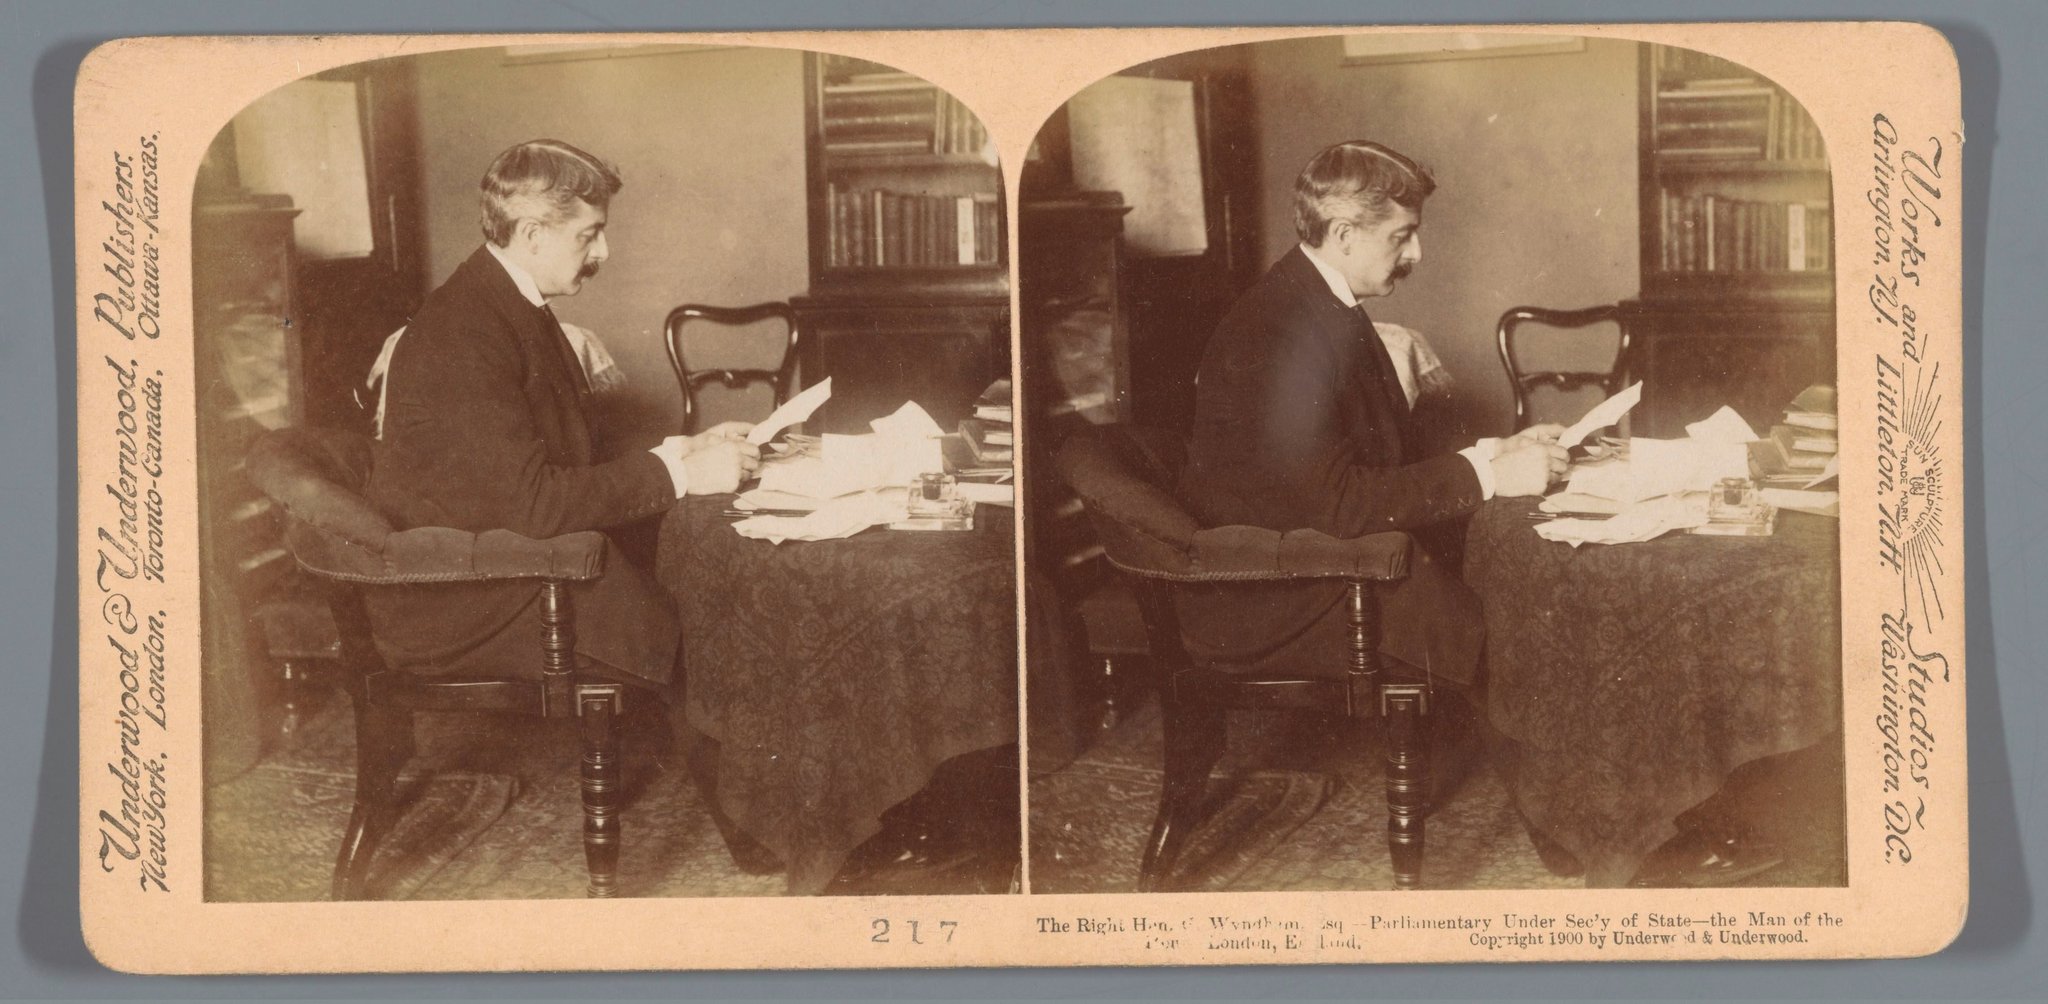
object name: stereograph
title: The Right Hon. G. Wyndham Esq - Parliamentary Under Sec'y of State - the Man of the [...] London, England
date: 1900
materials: cardboard, photographic support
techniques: albumen print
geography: south africa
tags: politician, george wyndham (4e hertog van egremont), politician, e.g. party leader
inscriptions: name: ‘Works and Studios Sun Sculpture trade mark Arlington N.J. Littleton N.H. Washington D.C.’, number: ‘217’